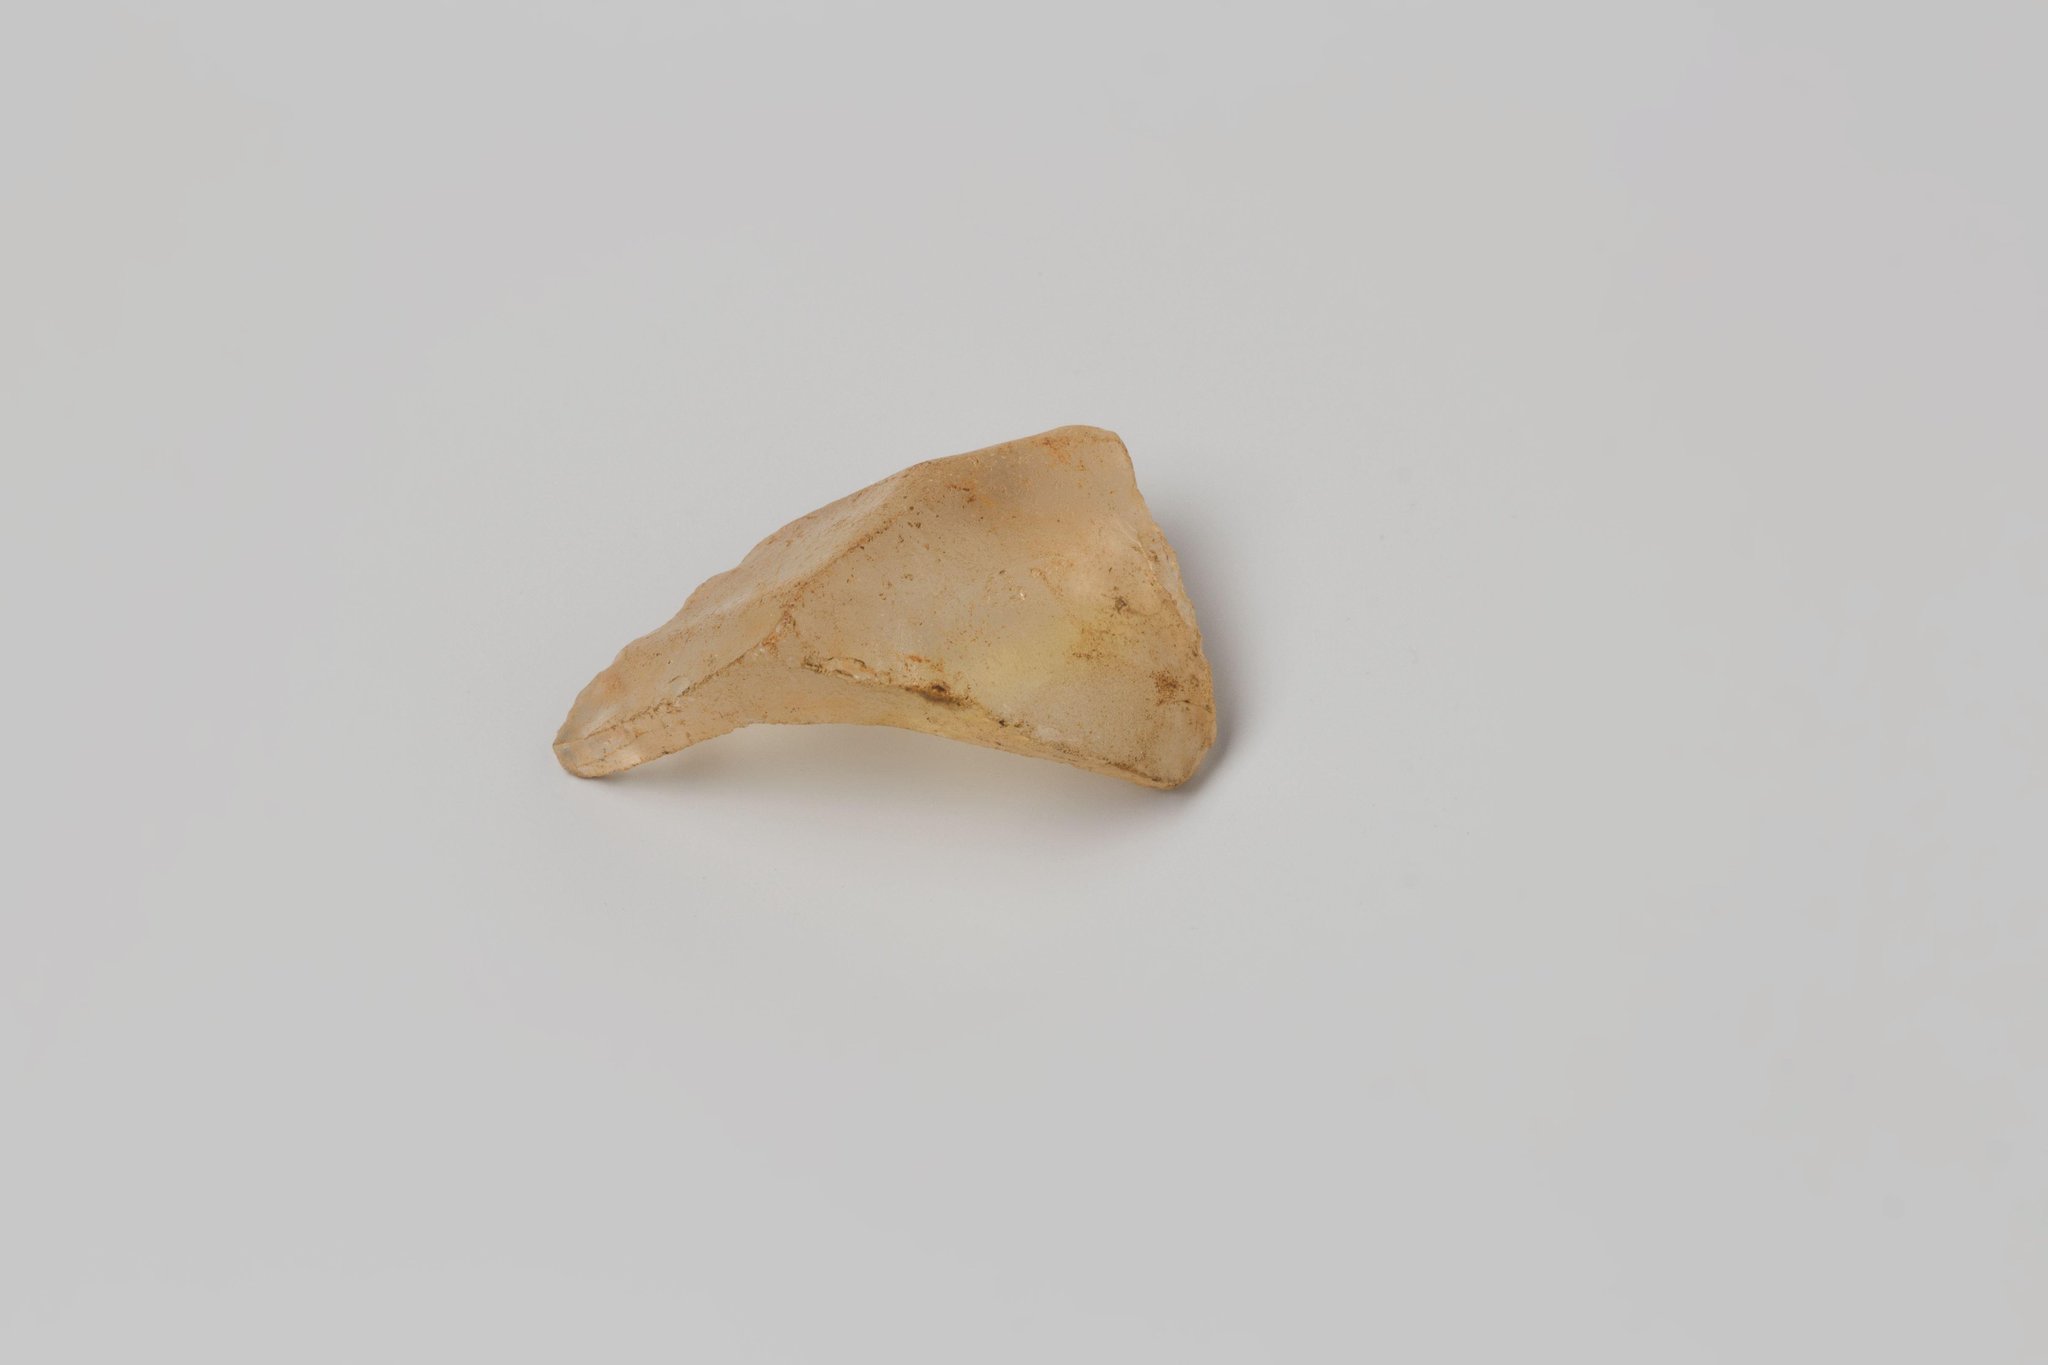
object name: tumbler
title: Fragment tuimelaar uit het wrak van de Oost-Indiëvaarder Hollandia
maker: Anonymous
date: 1700-1743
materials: glass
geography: netherlands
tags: verenigde oostindische compagnie, hollandia (schip), annet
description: Base, fragm, id. NG 1980-27H2057. Tumbler.